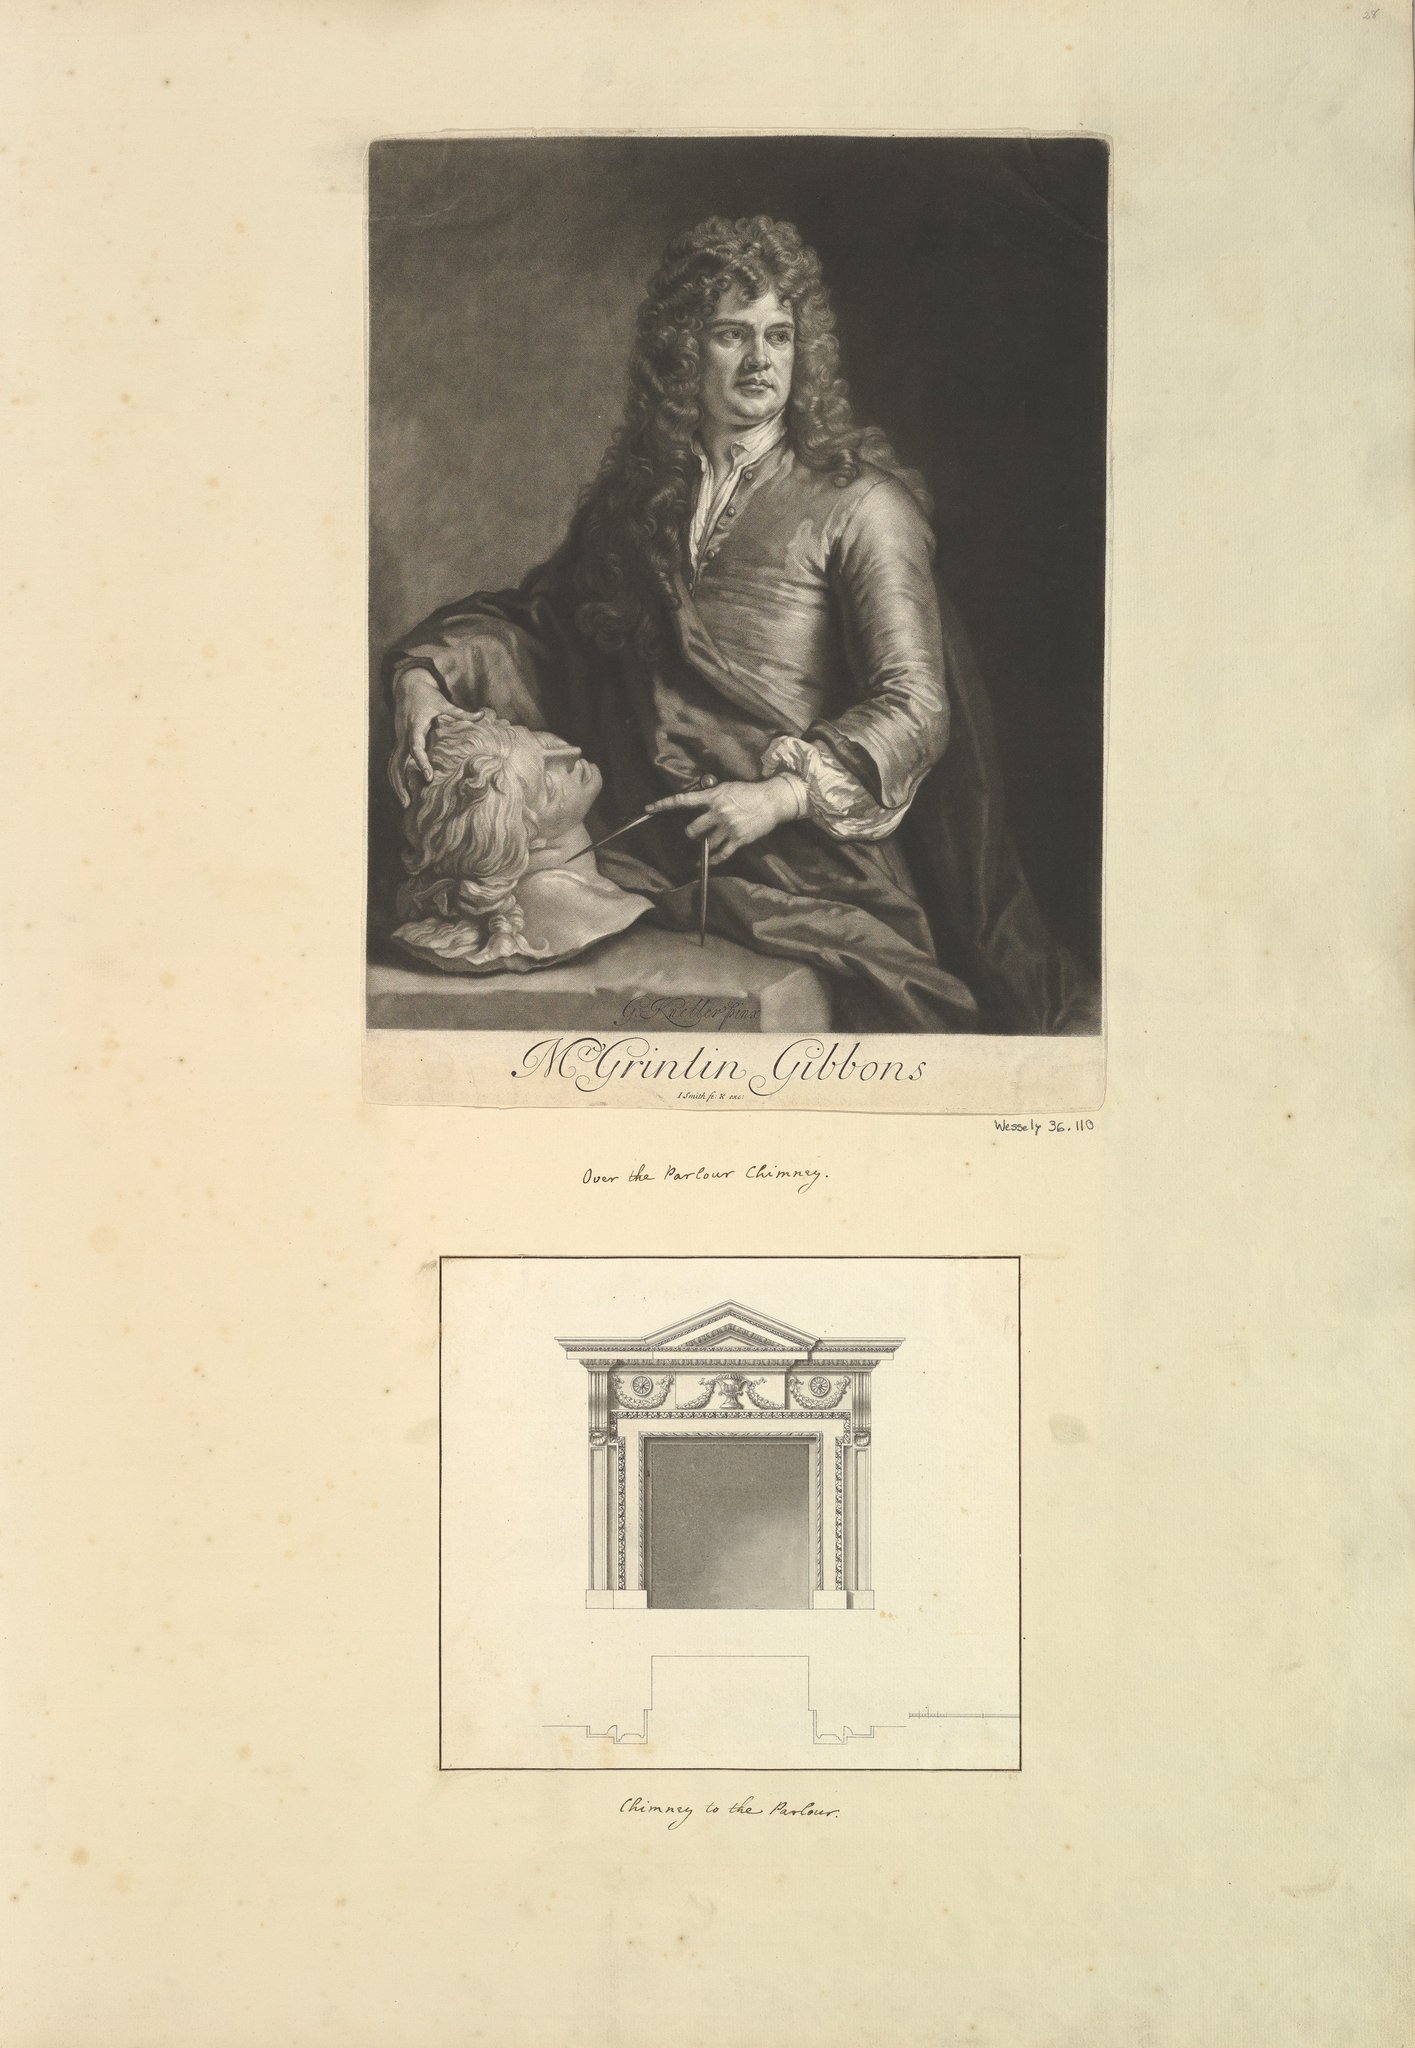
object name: print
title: Leaf from Aedes Walpolianae mounted with a print and a drawing (a): Portrait of Grinling Gibbons; (b) Chimney to the Parlour, Houghton Hall, Norfolk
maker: john smith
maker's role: artist and engraver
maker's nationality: british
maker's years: 1652-1743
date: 1690-1735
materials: ink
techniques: brush, mezzotint, pen, wash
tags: sculpture,heads,men,portraits